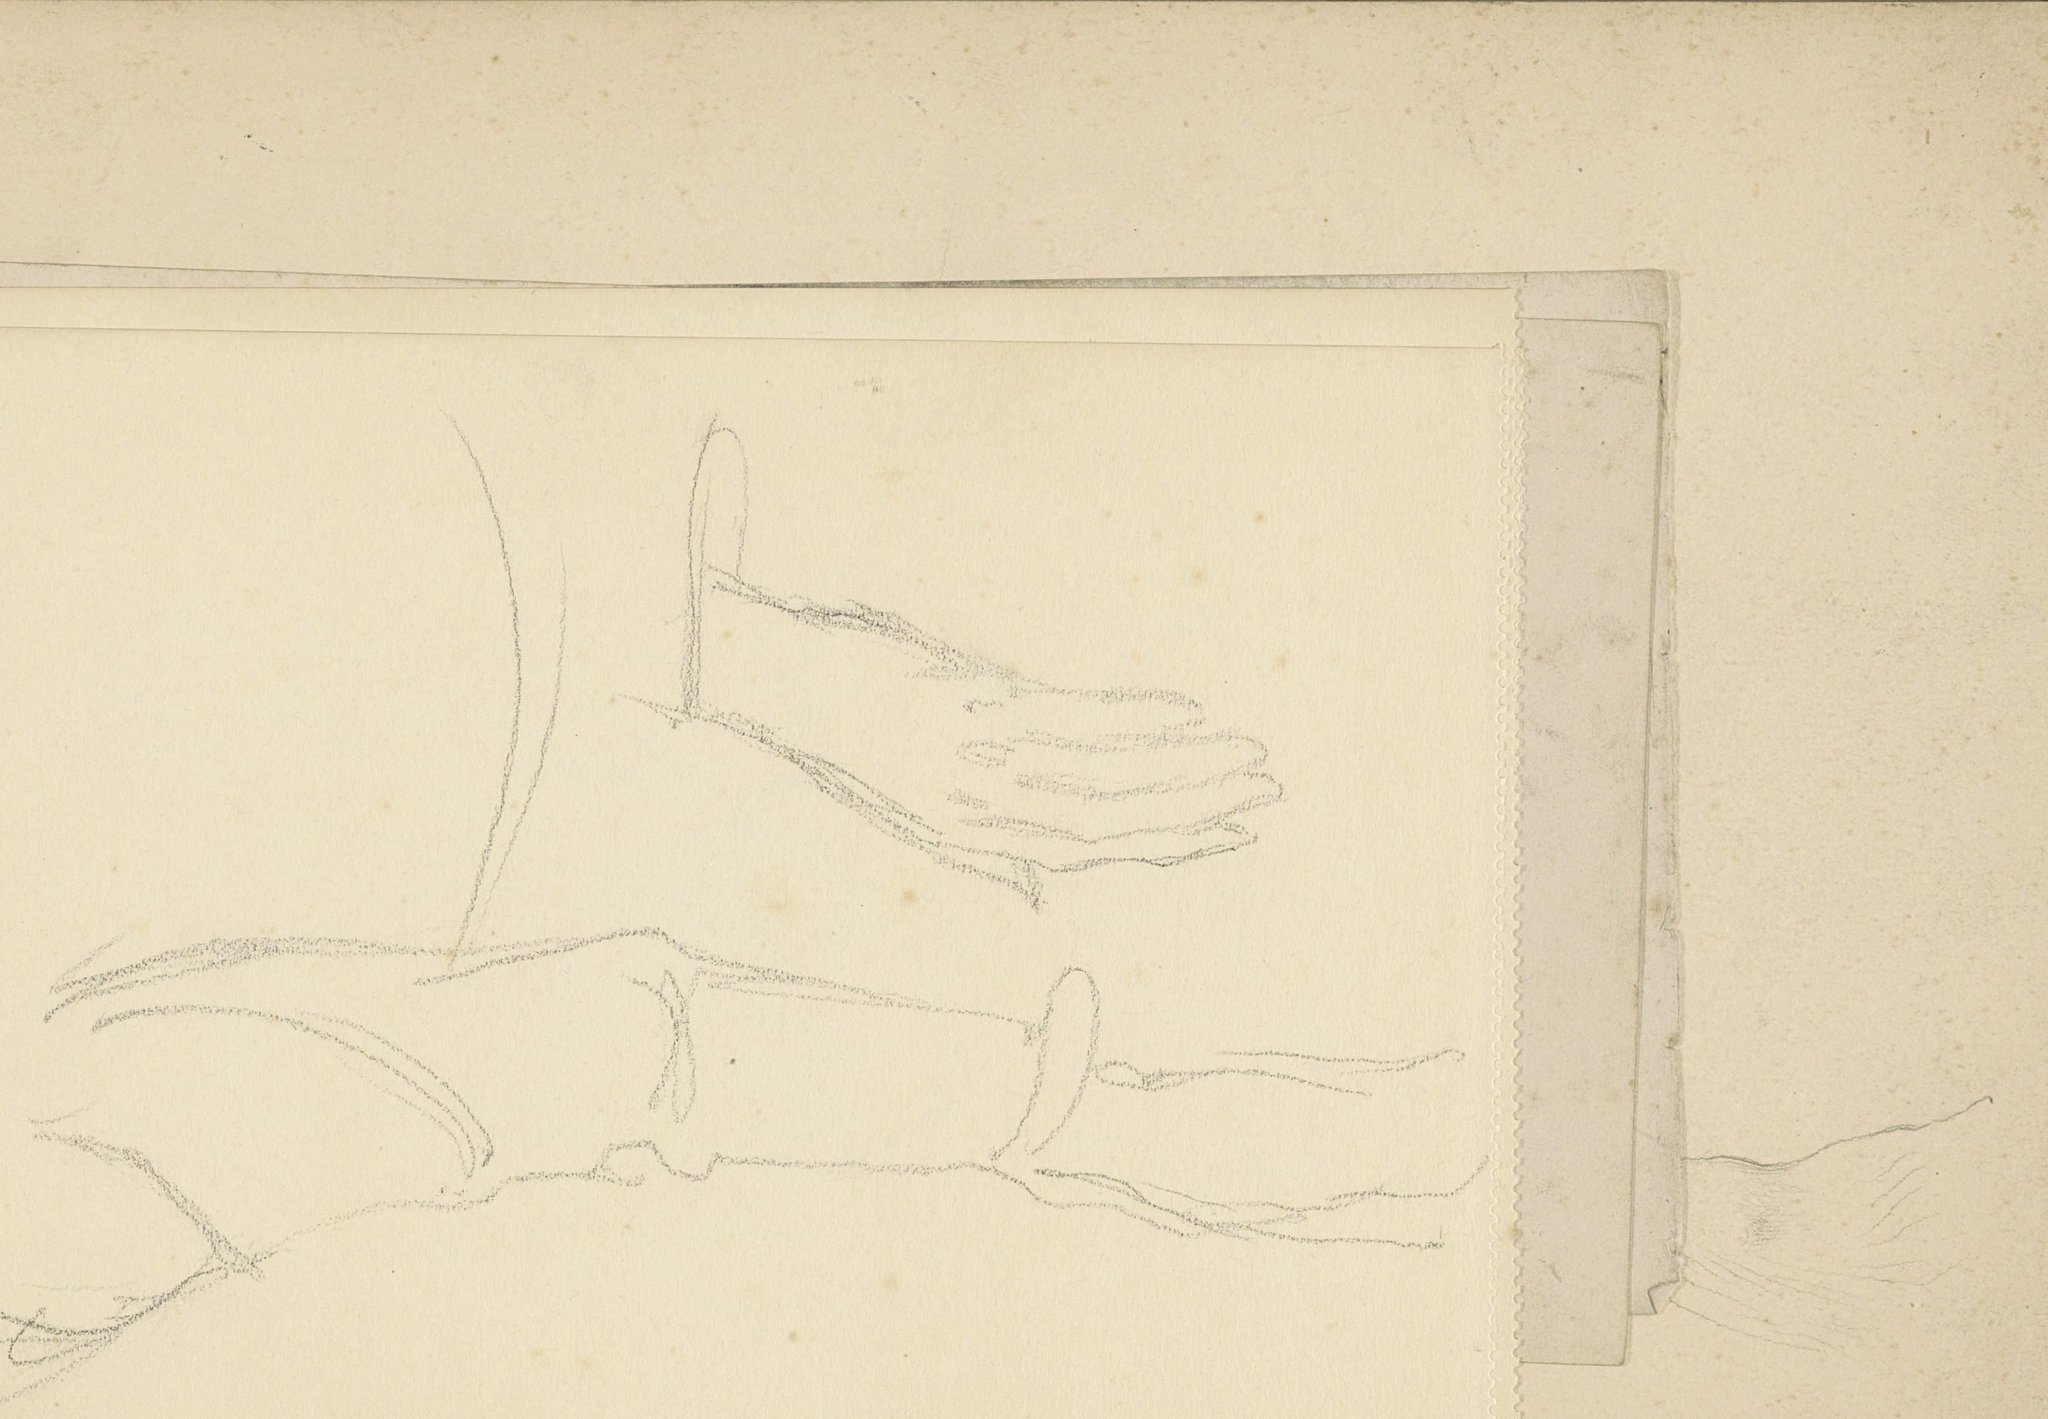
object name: sketchbook leaf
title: Arm en hand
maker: antoon derkinderen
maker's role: draughtsman, painter, print maker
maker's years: 1859-1925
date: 1869-1925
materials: paper, pencil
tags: arms, hand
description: Losse tekening tussen het voorste schutblad en blad 1 uit een schetsboek met 28 bladen.